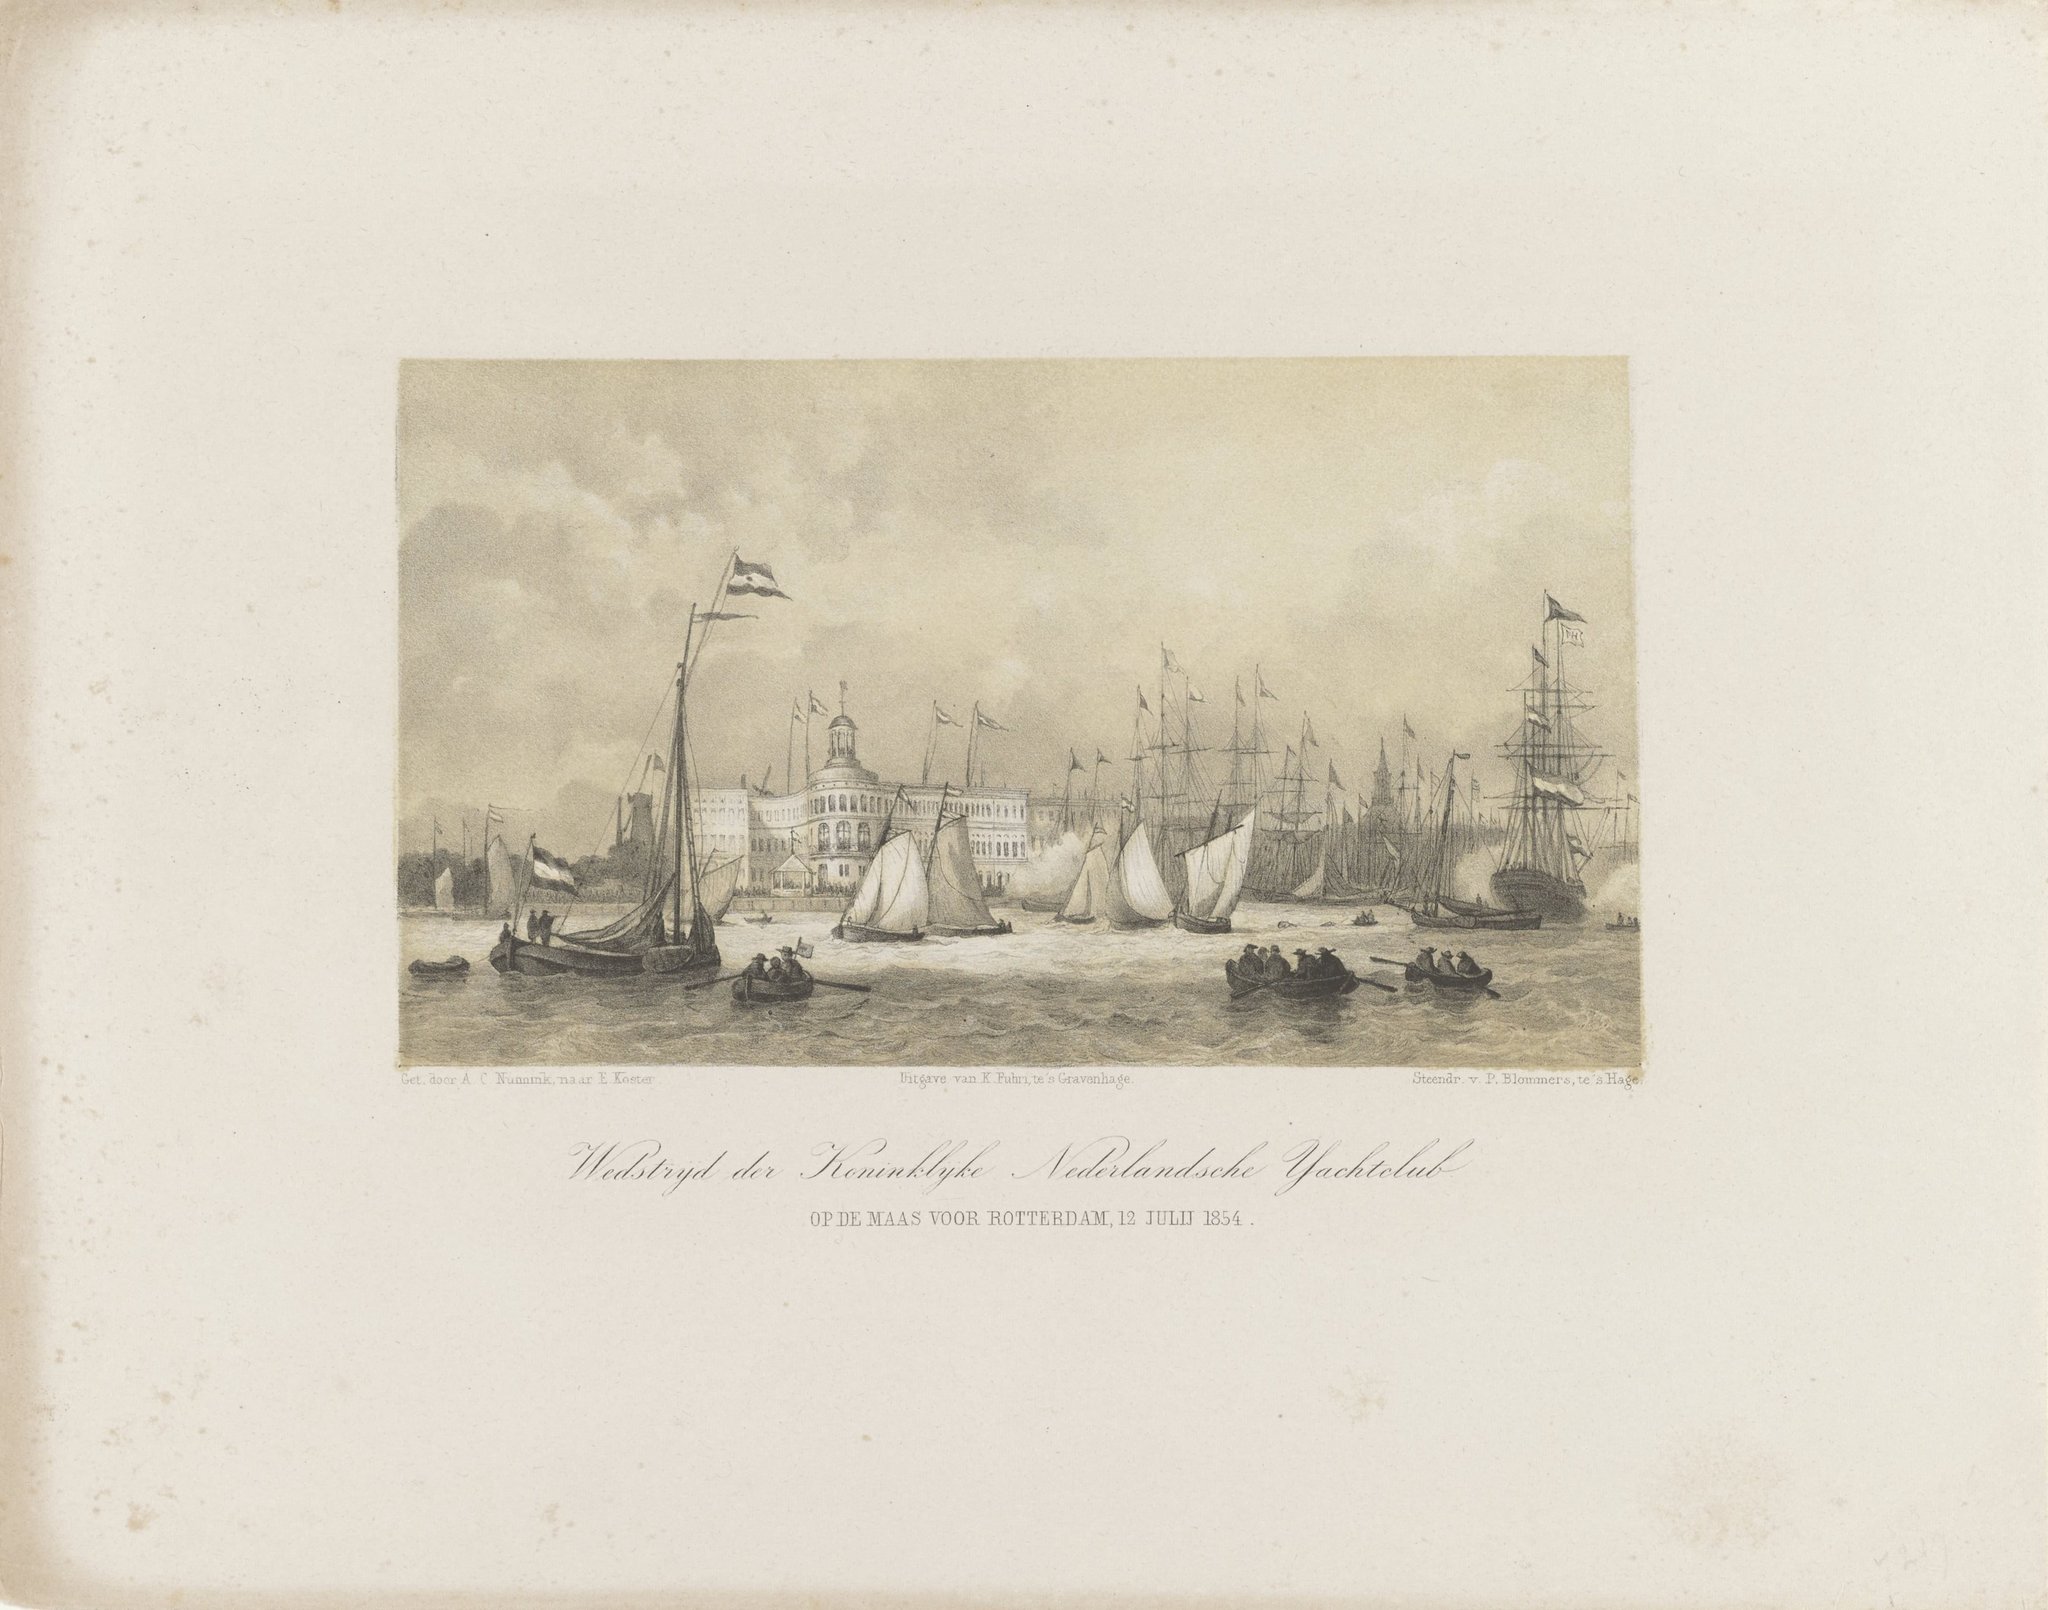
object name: print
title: De Maatschappij ter Bevordering van Toonkunst, haar Muziekfeest en de stad Rotterdam. herinnering aan het jaar 1854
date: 1855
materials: paper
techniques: tone lithography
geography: the hague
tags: sailing (sport), rotterdam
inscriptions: collector's mark: Lugt 2228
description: Zeilwedstrijd van de Koninklijke Nederlandsche Yachtclub op de Maas te Rotterdam, 12 juli 1854. Onderdeel van een serie van twaalf portretten naar daguerrotypieën en twaalf stadsgezichten. Ter gelegenheid van het Muziekfeest ter viering van het 25-jarige bestaan van de Maatschappij ter Bevordering van Toonkunst in Rotterdam, 12-15 juli 1854.